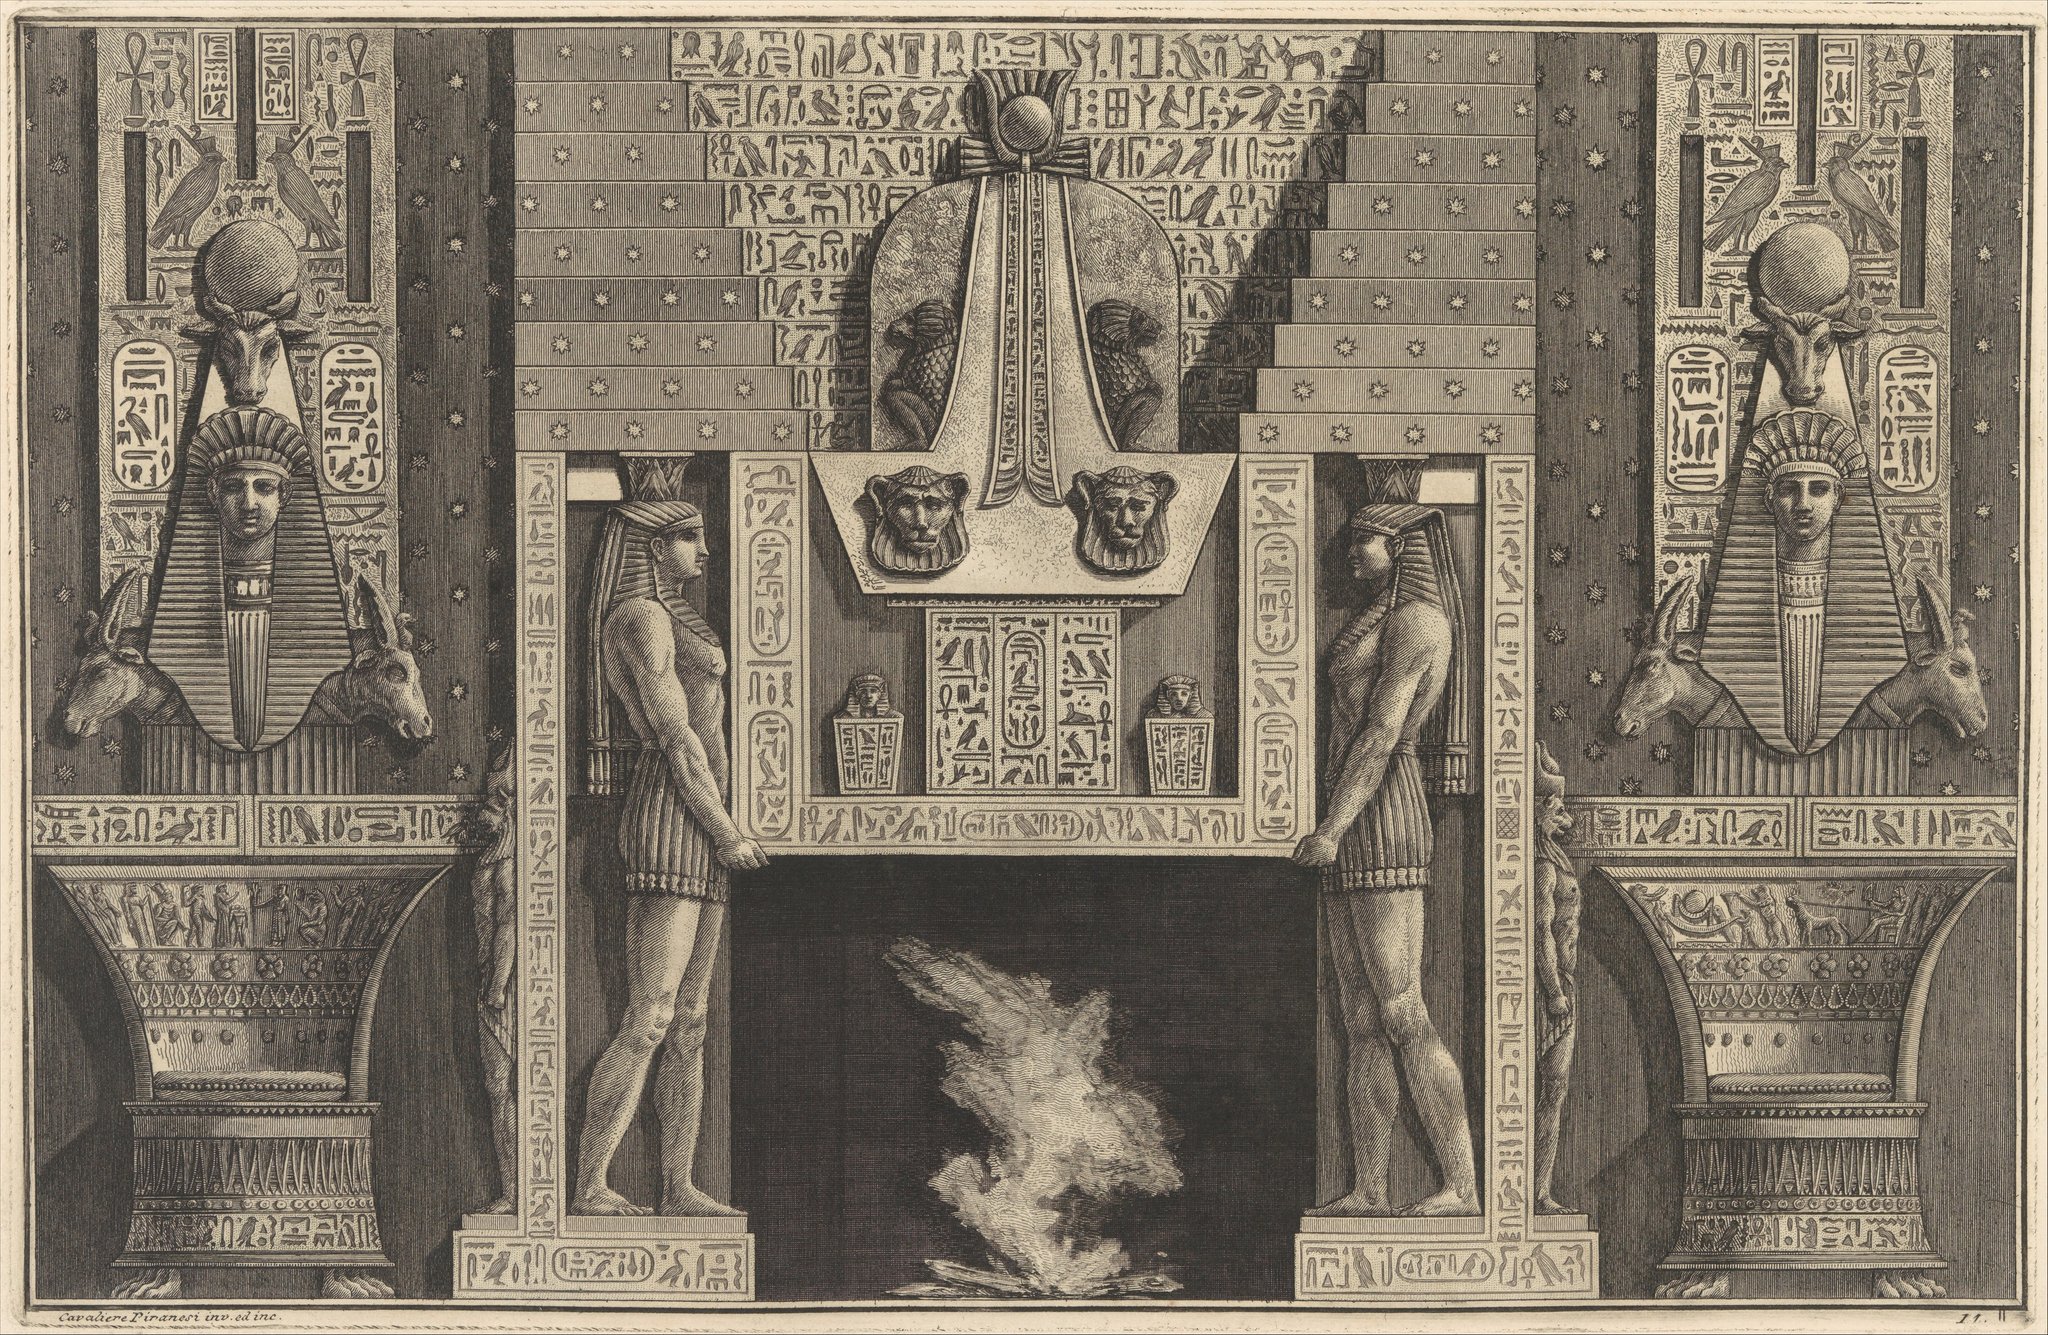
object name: print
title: Chimneypiece in the Egyptian style: Giant figures supporting the lintel, flanked by chairs, from "Diverse Maniere d'adornare i cammini..." (Diverse Ways of ornamenting chimneypieces...)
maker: giovanni battista piranesi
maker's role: artist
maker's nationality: italian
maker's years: 1720-1778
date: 1769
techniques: etching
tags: fireplaces